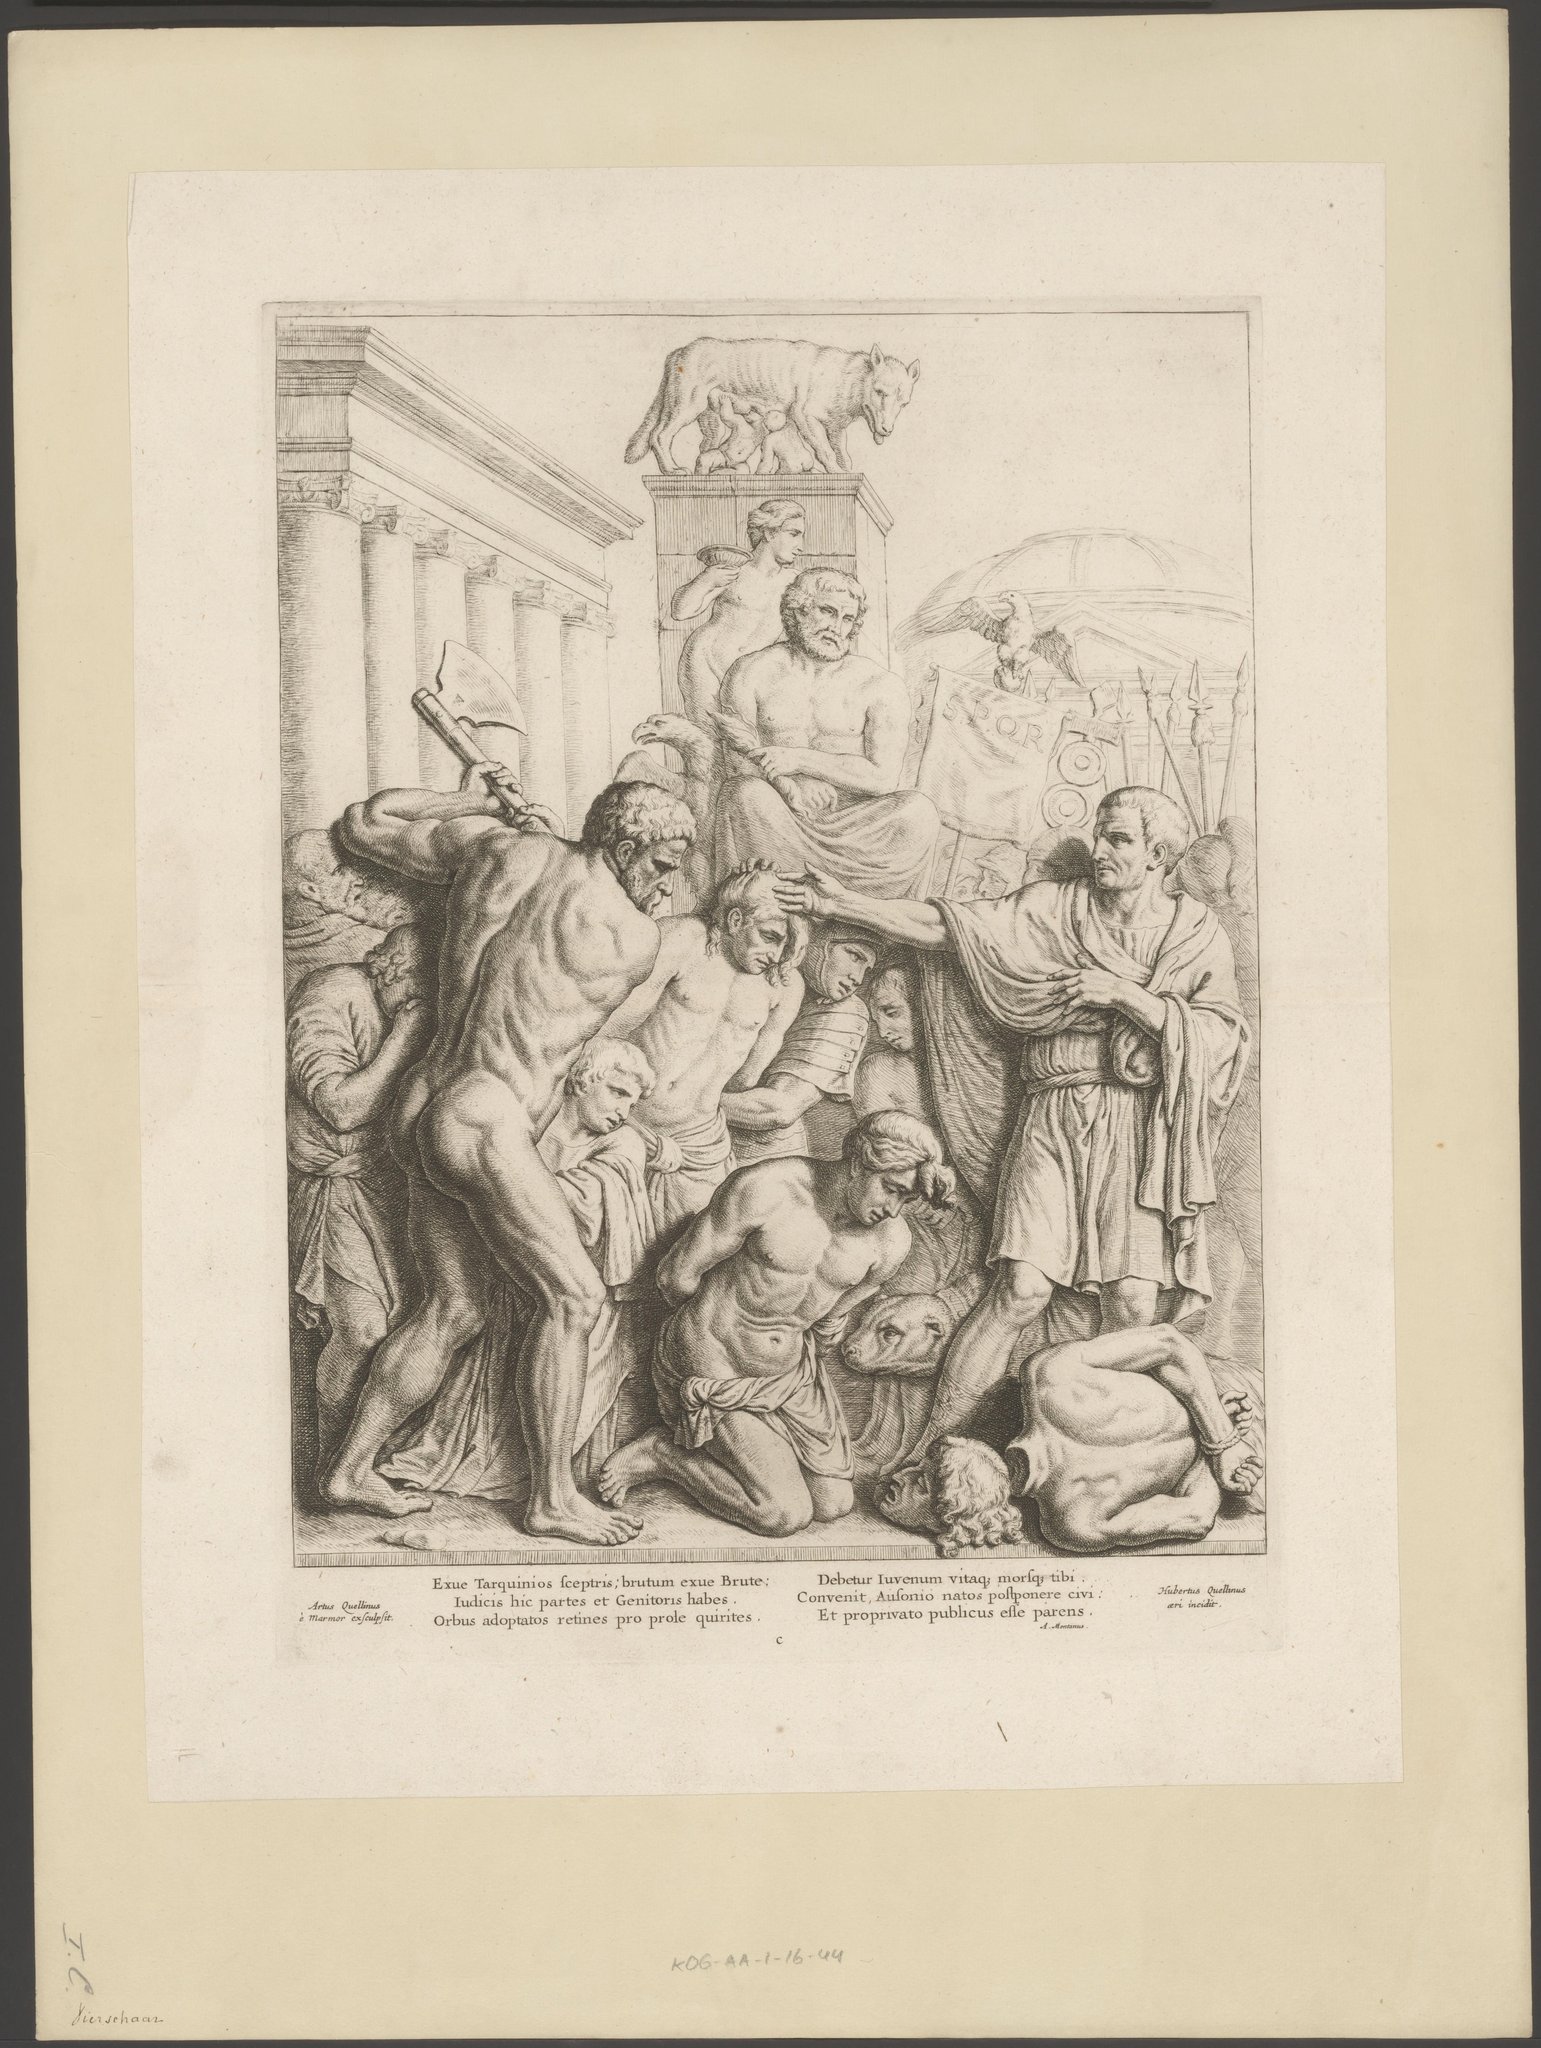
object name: print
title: Reliëf met het oordeel van Lucius Junius Brutus in de Vierschaar van het Stadhuis op de Dam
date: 1655-1665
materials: paper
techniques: engraving, etching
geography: amsterdam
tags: l. junius brutus has his two sons beheaded because they joined a conspiracy, townhall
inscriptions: collector's mark: ‘16’ Lugt 1641b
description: Prent gebruikt in: Prima pars. Praecipuarum effigierum ac ornamentorum, amplissimae Curiae Amstelrodamensis (…) / Het eerste deel. Van de voornaemste Statuen ende Ciraten, vant konstijck Stadhuys van Amstelredam, tmeeste in marmer gemaeckt, door Artus Quellinus, Beelthouwer der voorseyde Stadt / La Premier Partie. De plusieurs Figures et ornements, de la Maison de Ville d'Amsterdam (…). Amsterdam: Artus Quellinus (I), 1655. Zie RP-P-AO-22-1-1 voor bijhorende titelpagina. Zie RP-P-AO-22-1-2 voor bijhorend register. Zie RP-P-AO-22-1A, RP-P-AO-22-1B, RP-P-AO-22-1D-1, RP-P-AO-22-1D-2, RP-P-AO-22-1E, RP-P-AO-22-1F, RP-P-AO-22-1G, RP-P-AO-22-1H, RP-P-AO-22-1I, RP-P-AO-22-1K-1, RP-P-AO-22-1K-2, RP-P-AO-22-1K-3, RP-P-AO-22-1K-4, RP-P-AO-22-1K-5, RP-P-AO-22-1L-1, RP-P-AO-22-1L-2, RP-P-AO-22-1M-1, RP-P-AO-22-1M-2, RP-P-AO-22-1N-1, RP-P-AO-22-1N-2, RP-P-AO-22-1N-3, RP-P-AO-22-1N-4, RP-P-AO-22-1N-5, RP-P-AO-22-1O-1, RP-P-AO-22-1O-2, RP-P-AO-22-1O-3, RP-P-AO-22-1O-4, RP-P-AO-22-1P-1, RP-P-AO-22-1P-2, RP-P-AO-22-1P-3, RP-P-AO-22-1P-4, RP-P-AO-22-1Q-1, RP-P-AO-22-1Q-2, RP-P-AO-22-1Q-3, RP-P-AO-22-1Q-4, RP-P-AO-22-1R-1, RP-P-AO-22-1R-2, RP-P-AO-22-1R-3, RP-P-AO-22-1R-4, RP-P-AO-22-1R-5, RP-P-AO-22-1S-1, RP-P-AO-22-1S-2, RP-P-AO-22-1S-3, RP-P-AO-22-1S-4, RP-P-AO-22-1S-5, RP-P-AO-22-1T-1 en RP-P-AO-22-1T-2 voor andere prenten uit deze publicatie. Zelfde staat van prent ook gebruikt in: Prima pars. Praecipuarum effigierum ac ornamentorum, amplissimae Curiae Amstelrodamensis (…) / Het eerste deel. Van de voornaemste Statuen ende Ciraten, vant konstijck Stadhuys van Amstelredam, tmeeste in marmer gemaeckt, door Artus Quellinus, Beelthouwer der voorseyde Stadt / La Premier Partie. De plusieurs Figures et ornements, de la Maison de Ville d'Amsterdam (…). Amsterdam: Frederik de Wit, 1665. Latere staat van prent ook gebruikt in: Architecture peinture et sculpture de la Maison de Ville d'Amsterdam, representee en CIX. figures en taille-douce (…). Amsterdam: David Mortier, 1719. En in: Architecture peinture et sculpture de la Maison de Ville d'Amsterdam, representee en CIX. figures en taille-douce (…). Amsterdam: Gerard Valck, 1719. En in: Bouw schilder en beeldhouwkonst, van het Stadhuis te Amsteldam, vertoont in CIX figuuren (…). Amsterdam: Covens & Mortier & Covens Jr., s.a. (1774-1783). Zie BK-AM-51-21 voor model van beeld.